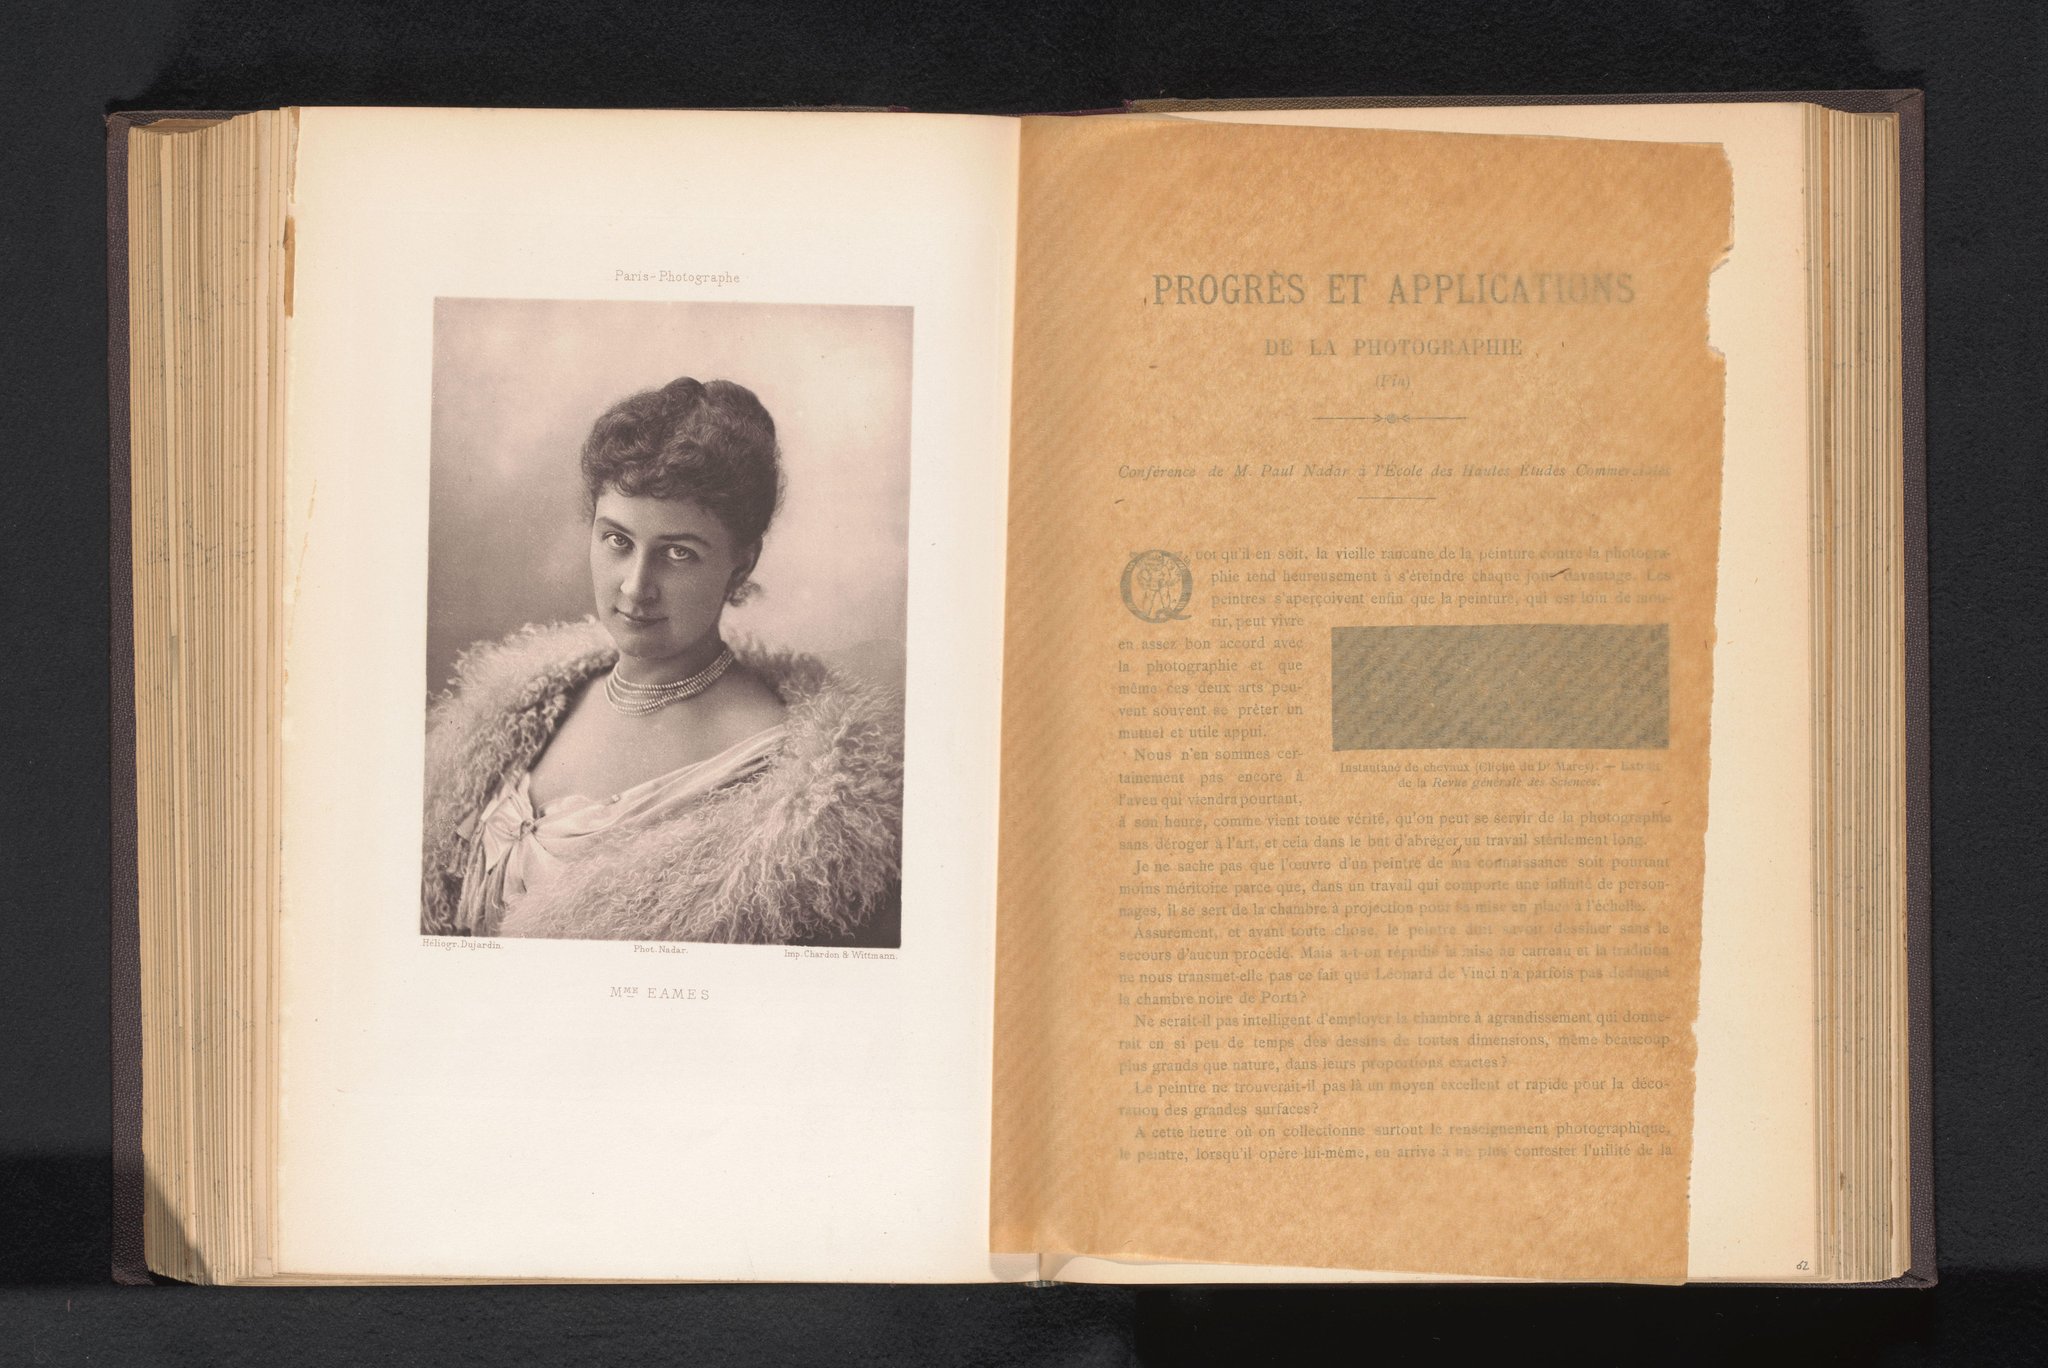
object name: page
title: Portret van Emma Eames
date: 1882-1892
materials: paper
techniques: photoaquatint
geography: paris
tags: portrait of opera-singer